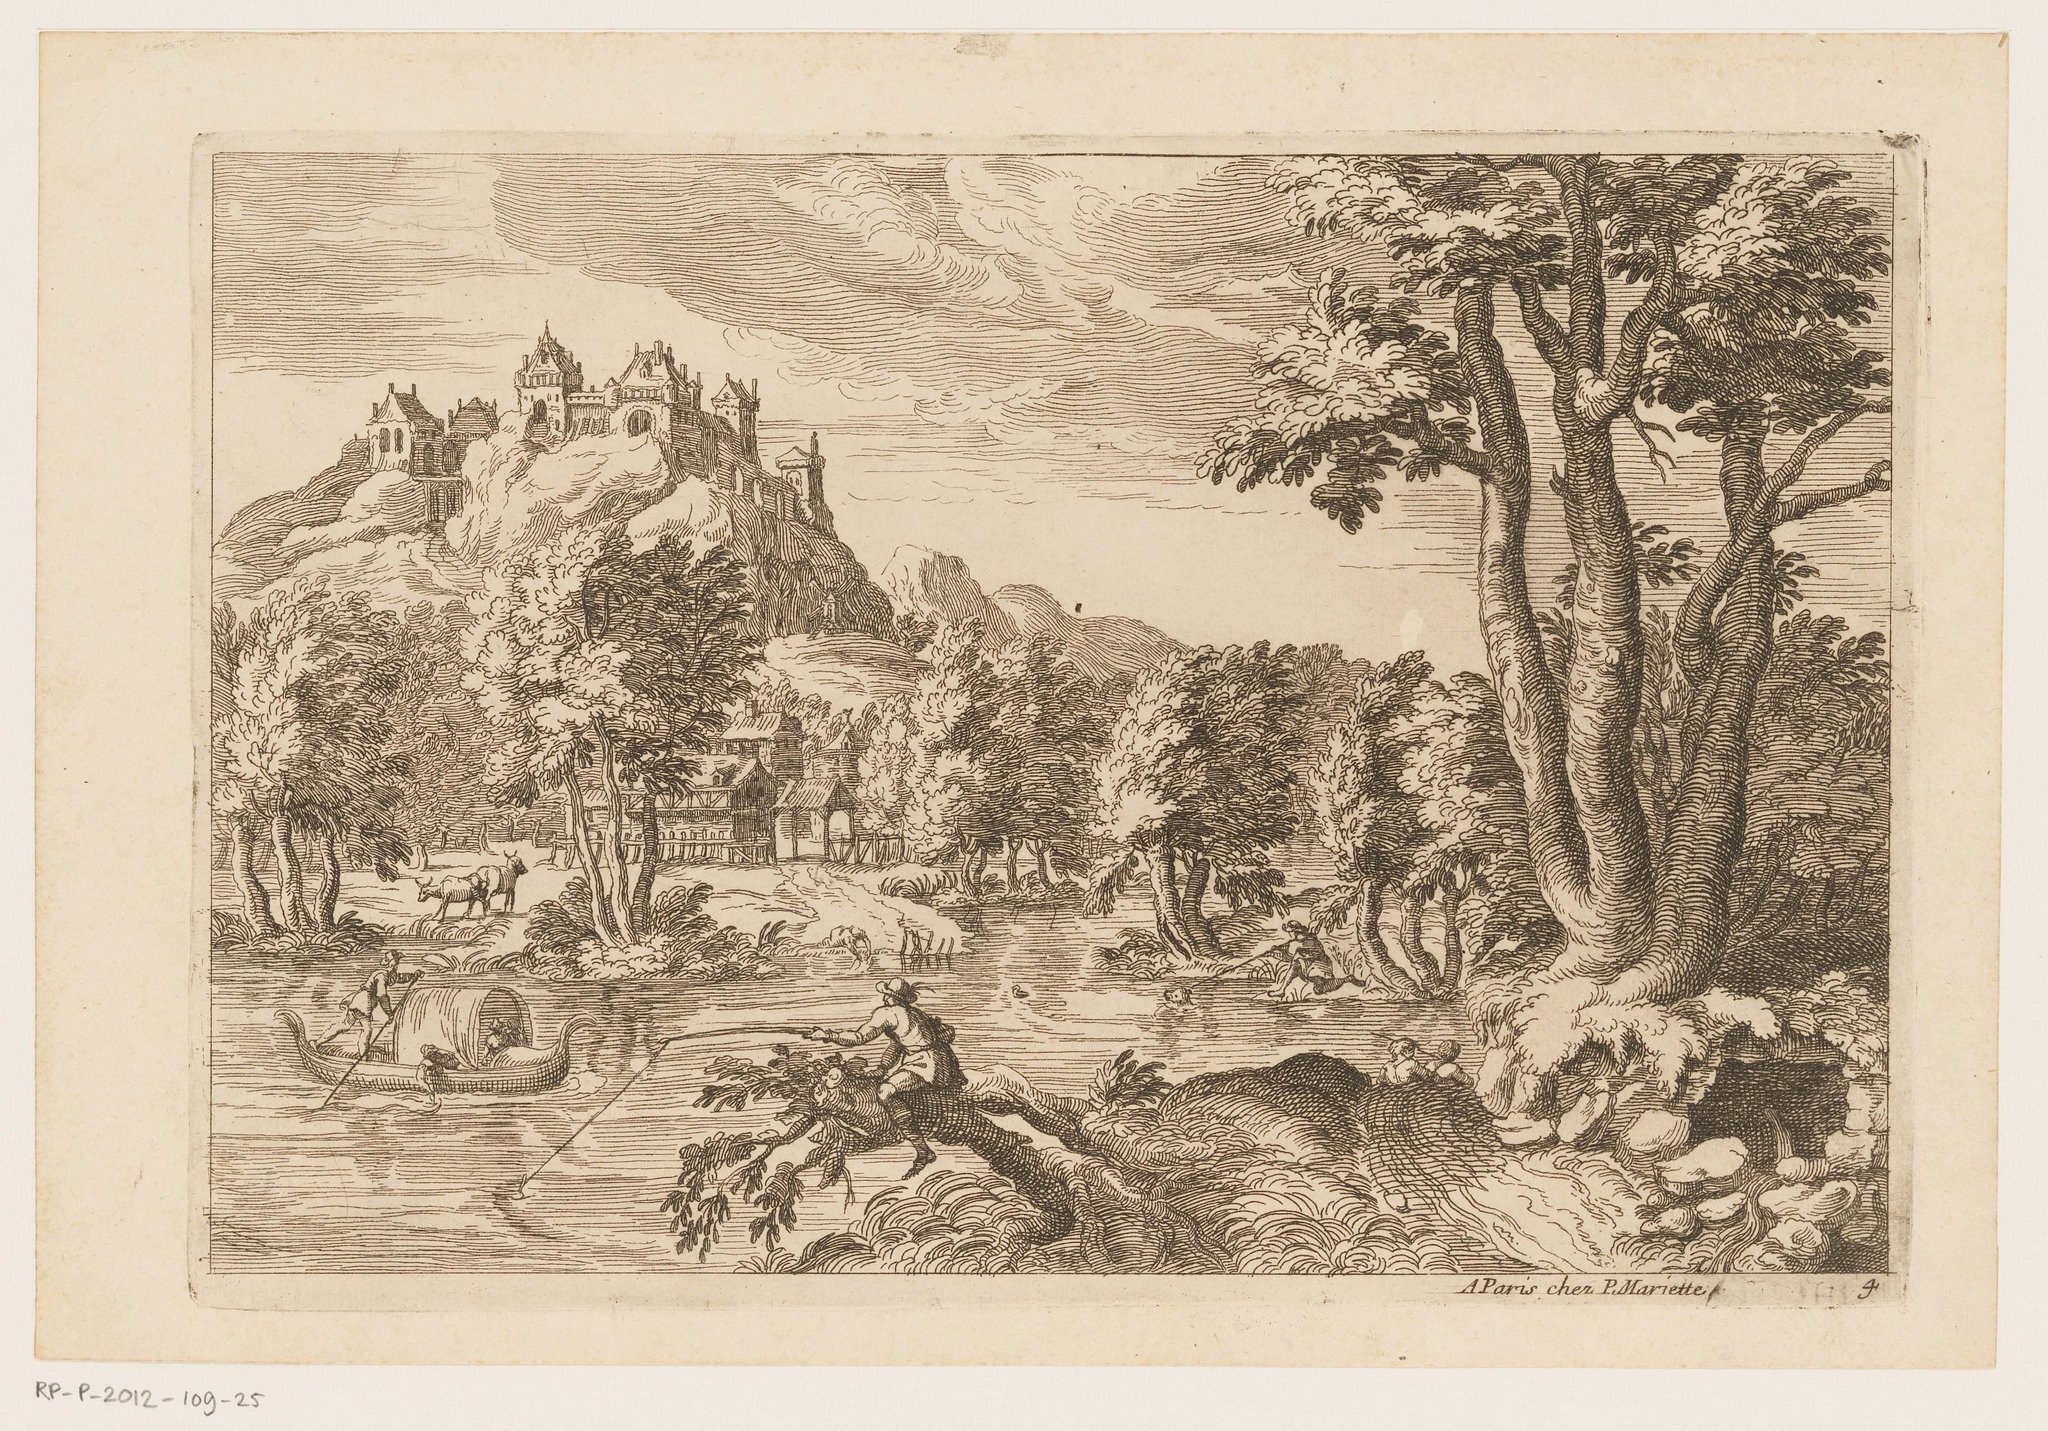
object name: print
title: Landschap met hengelaars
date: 1663-1726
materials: paper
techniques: etching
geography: paris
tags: river, angling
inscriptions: collector's mark: Lugt 3473, collector's mark: Lugt 3474, collector's mark: Lugt 2228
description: Maakt deel uit van vierentwintigdelige serie met landschappen naar Titiaan en Campagnola.